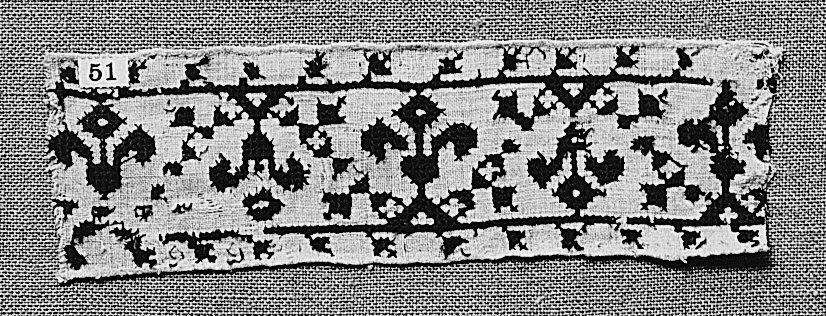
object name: band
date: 1701-1800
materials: linen, silk